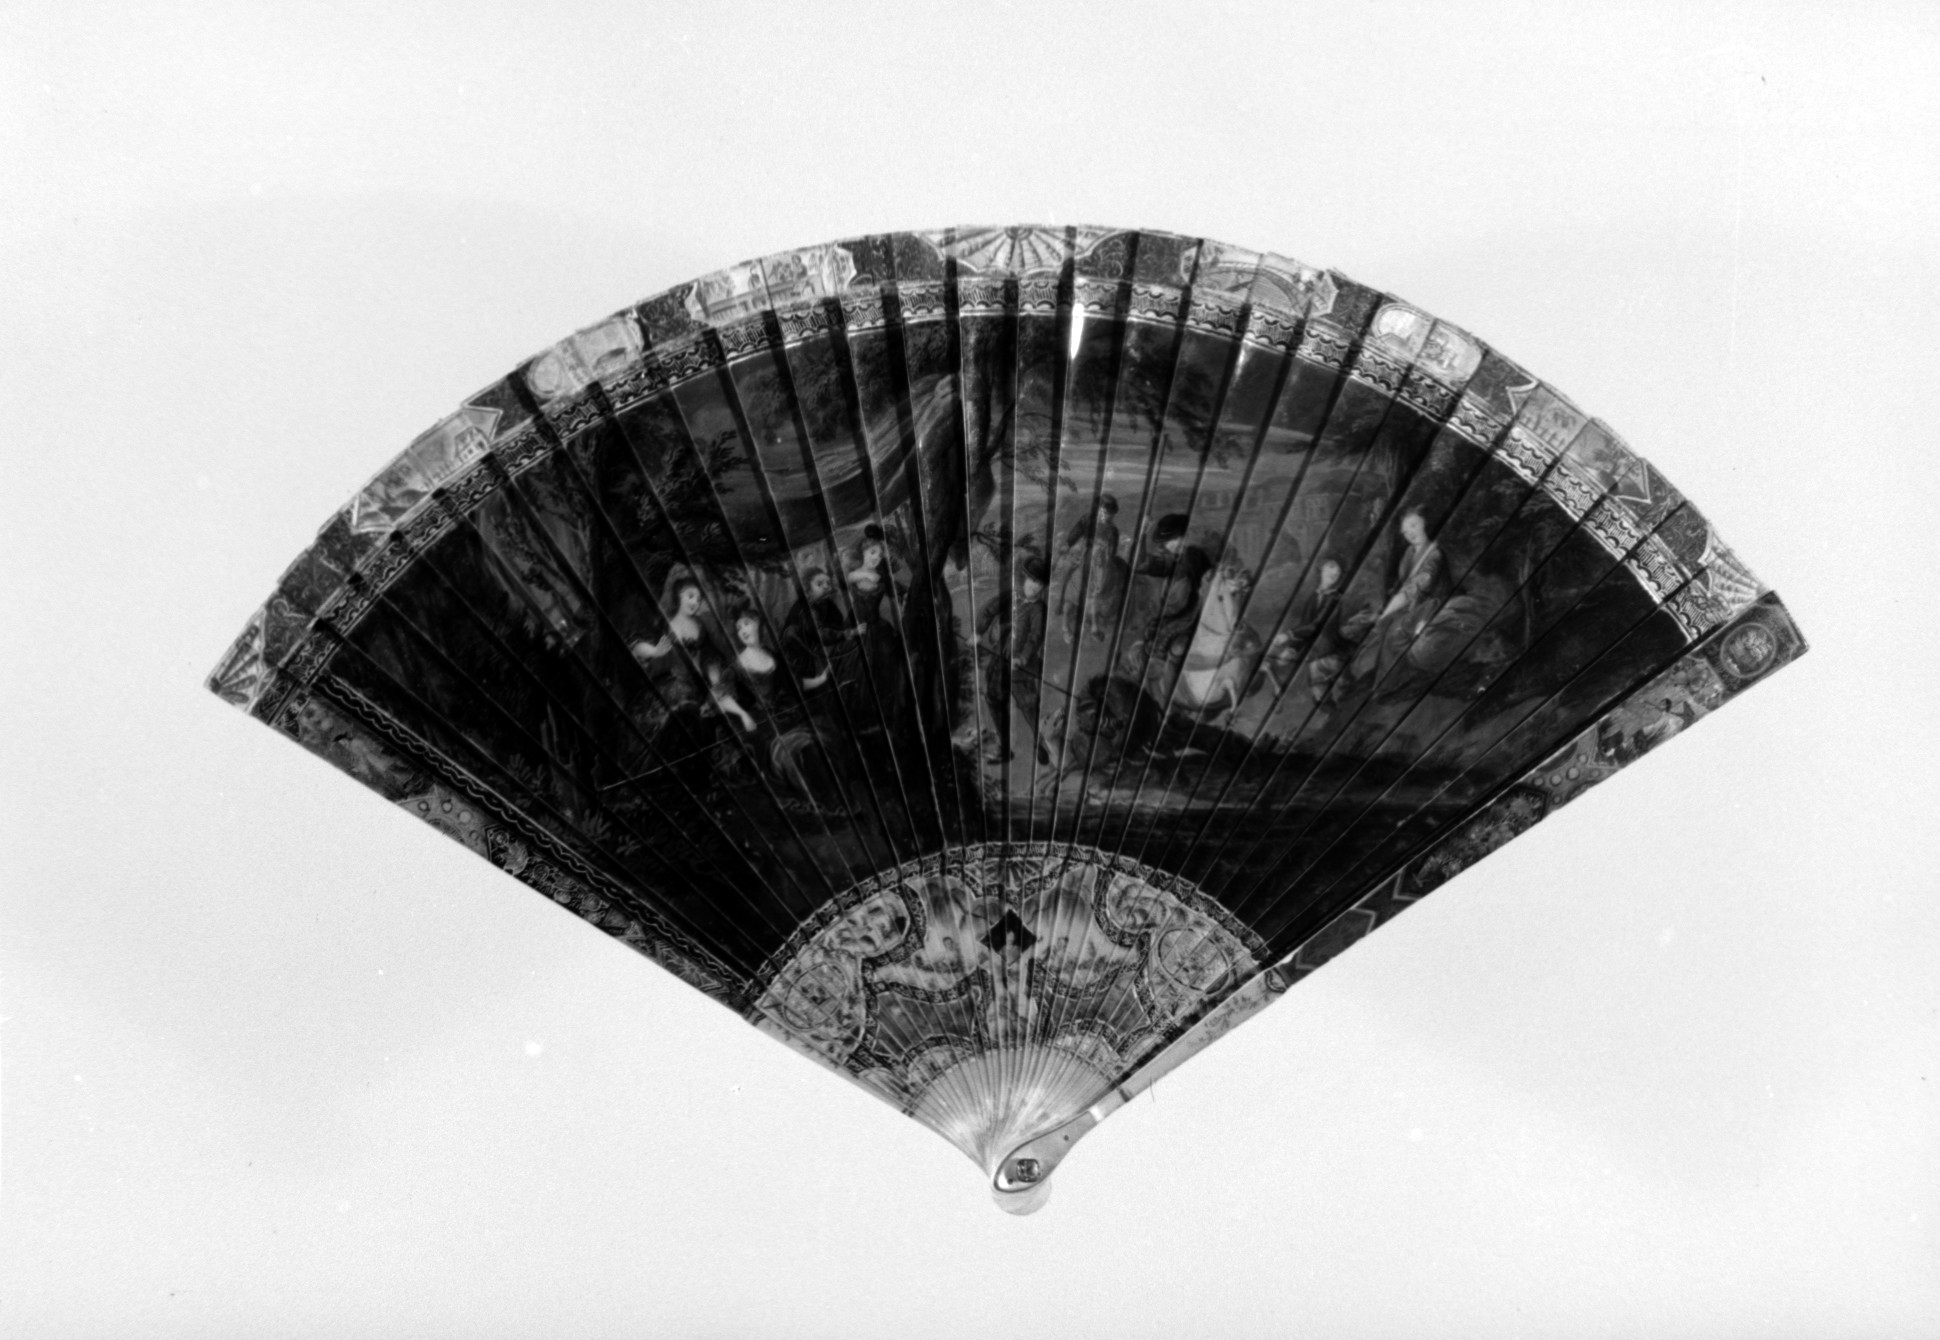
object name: fan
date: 1701-1800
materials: ivory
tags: men,women,horses